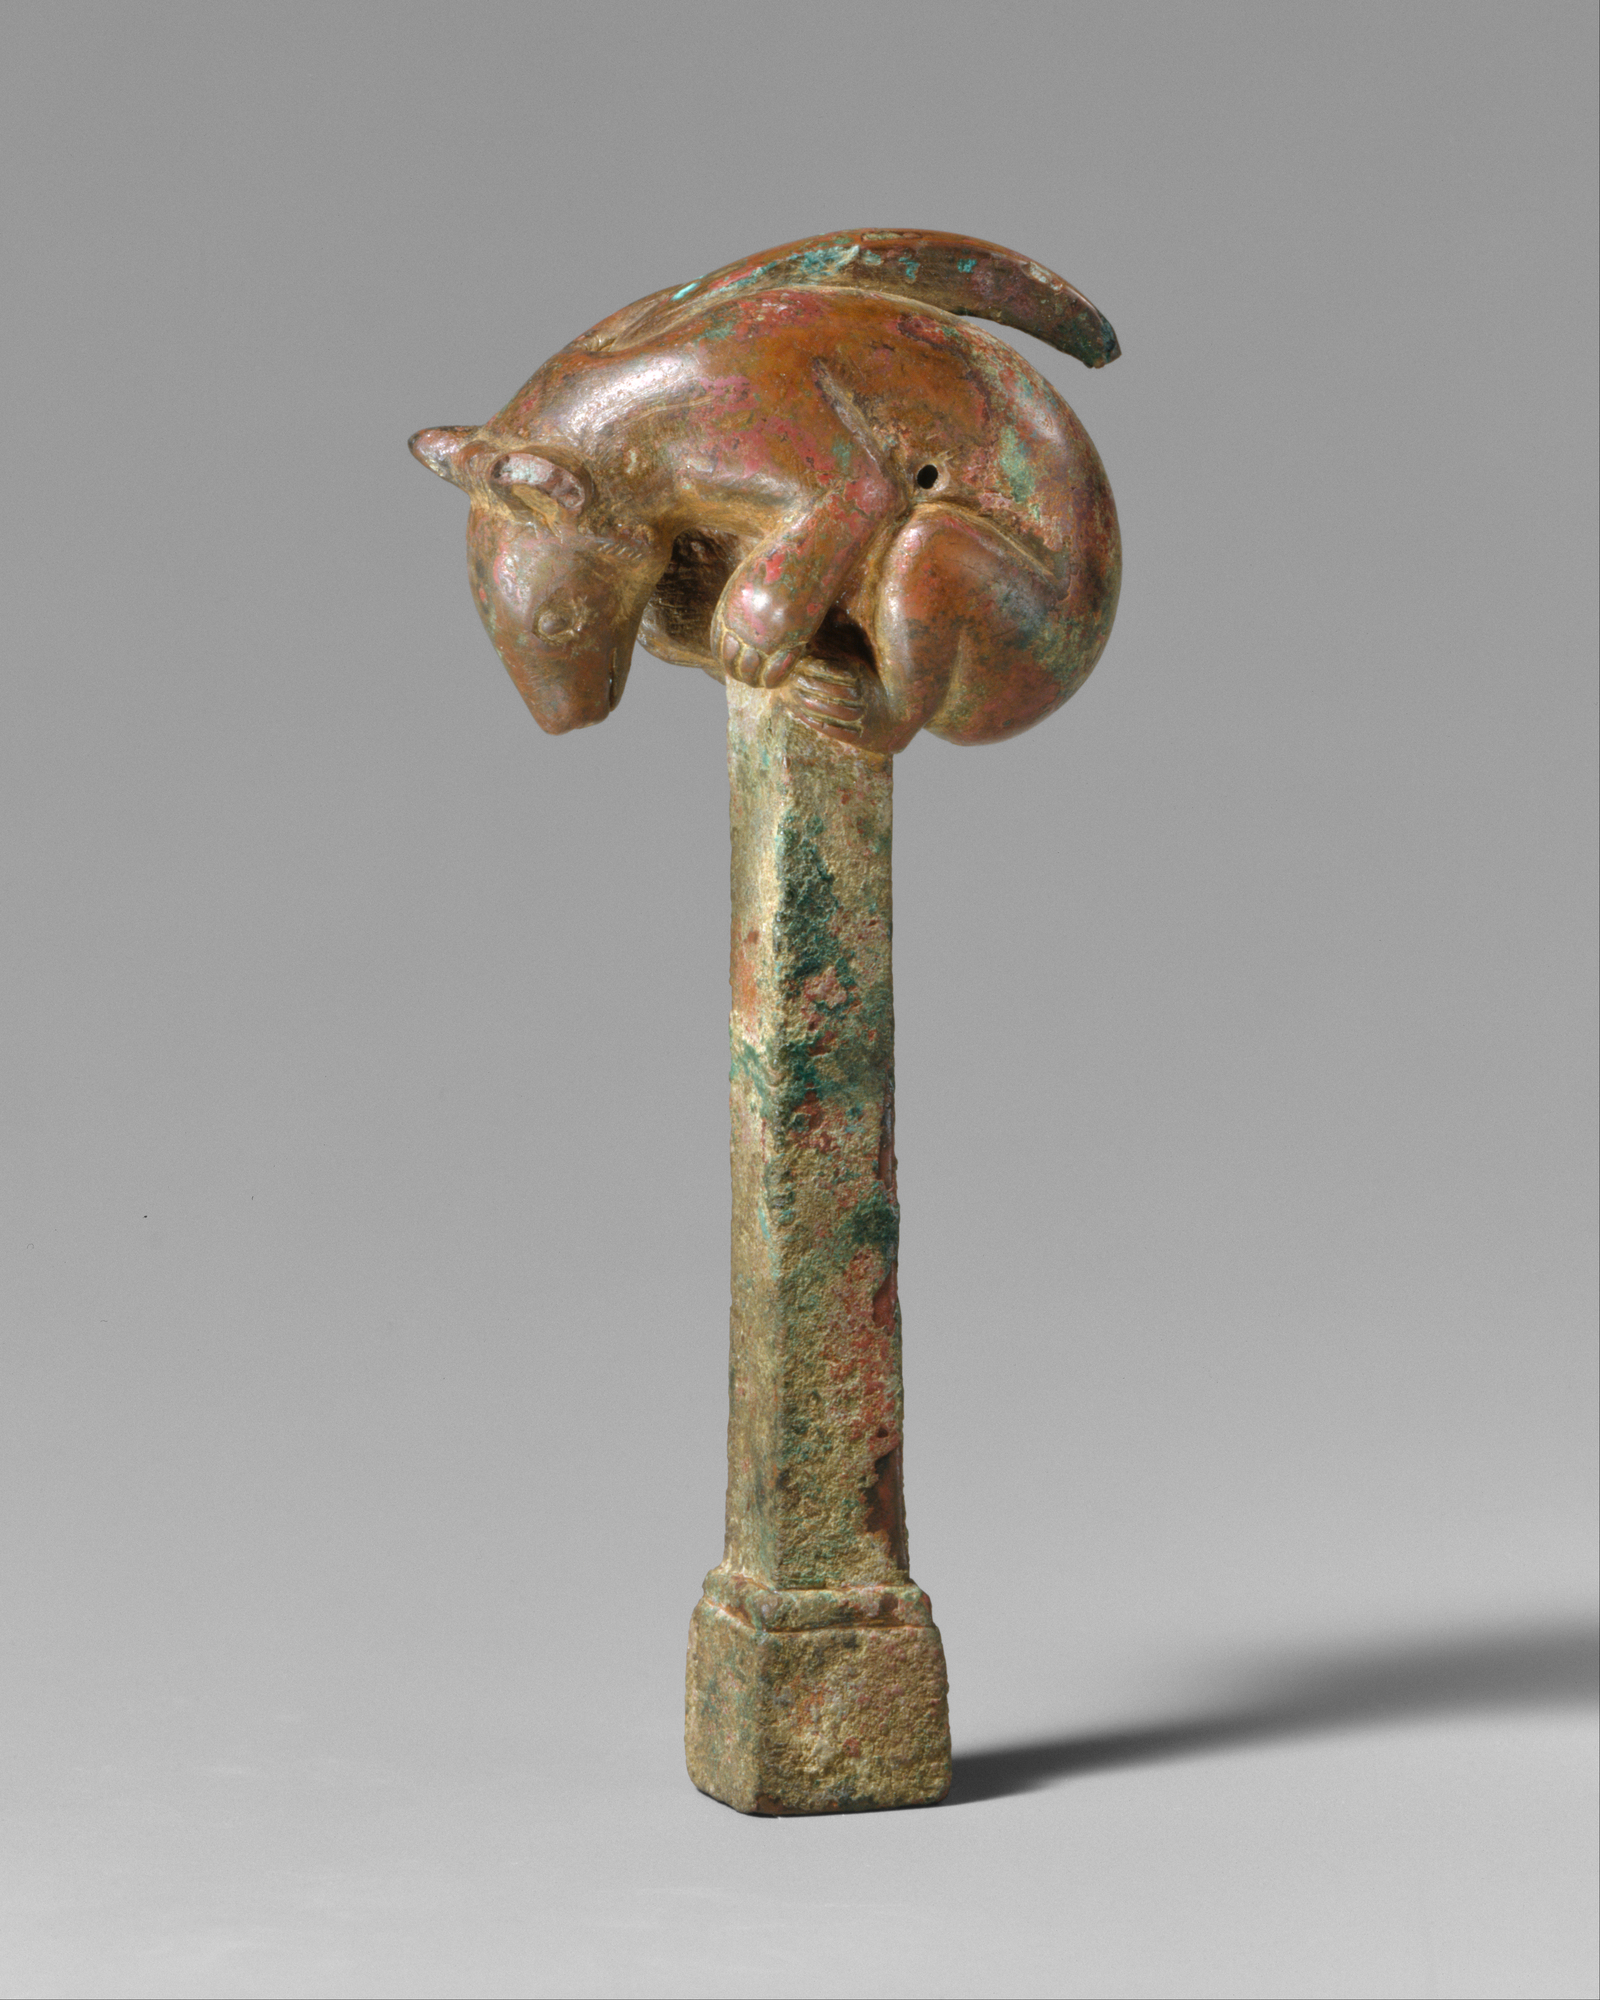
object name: tuning key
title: Tuning Key for a Zither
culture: north chinese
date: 300-201 BCE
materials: bronze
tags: animals